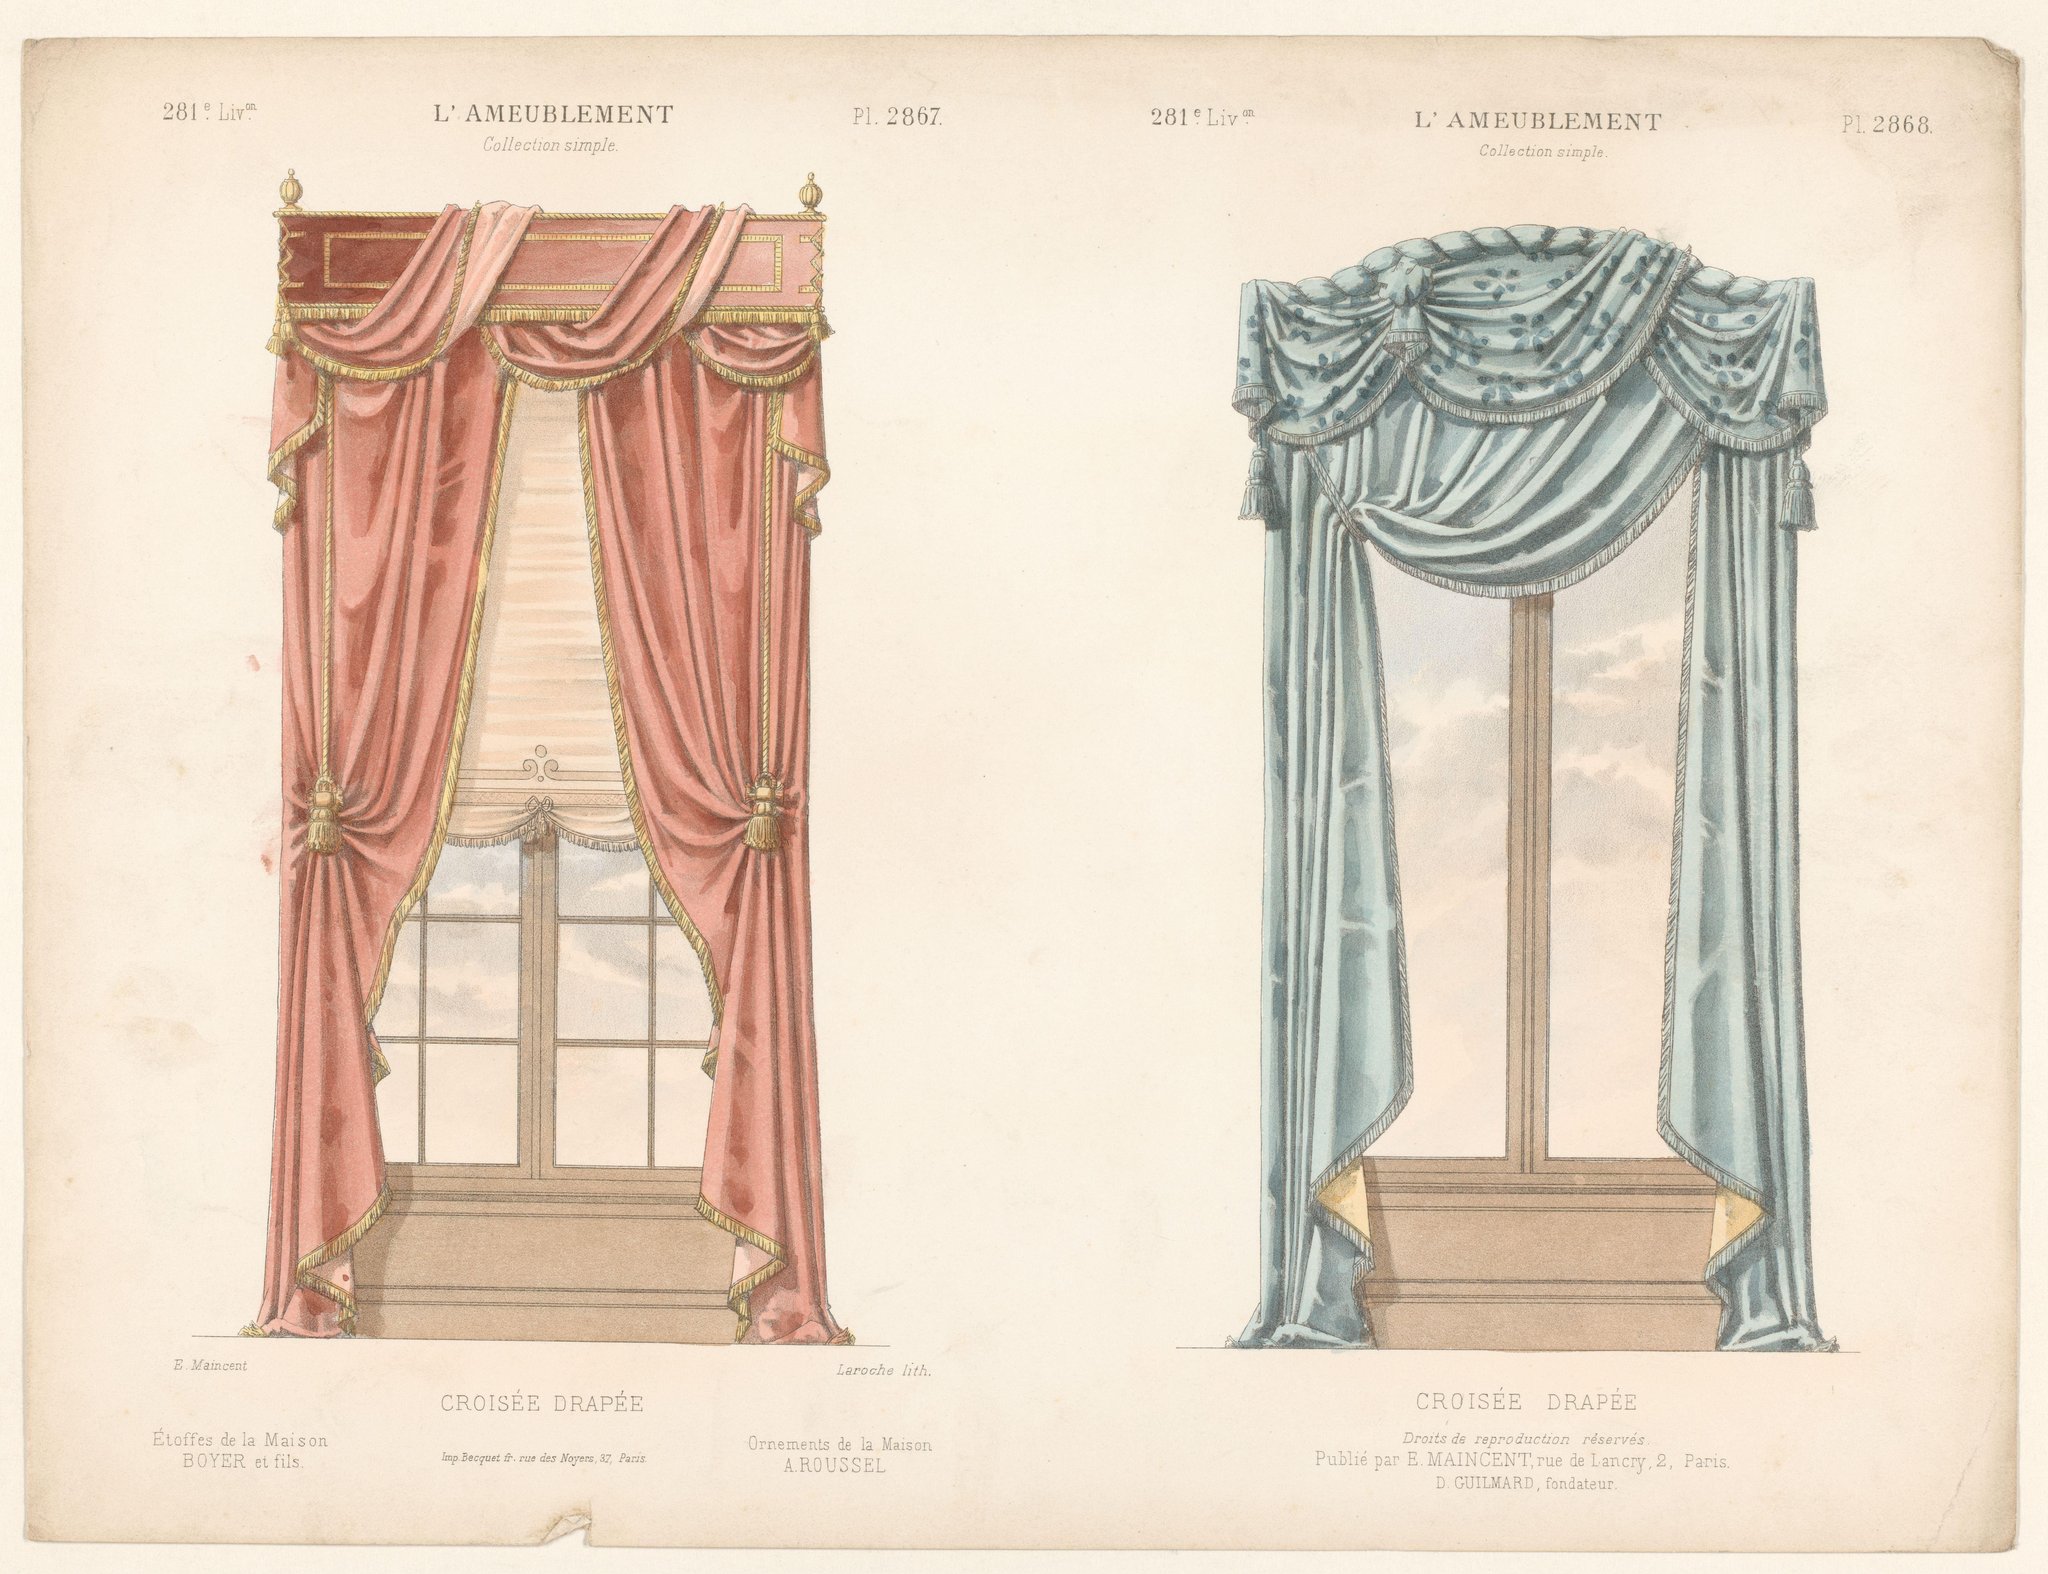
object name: print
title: Croisée drapée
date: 1885-1895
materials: paper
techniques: hand coloring, lithograph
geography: paris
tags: window, hangings and drapery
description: Twee vensters met gedrapeerde gordijnen. Prent uit 281e Livraison.